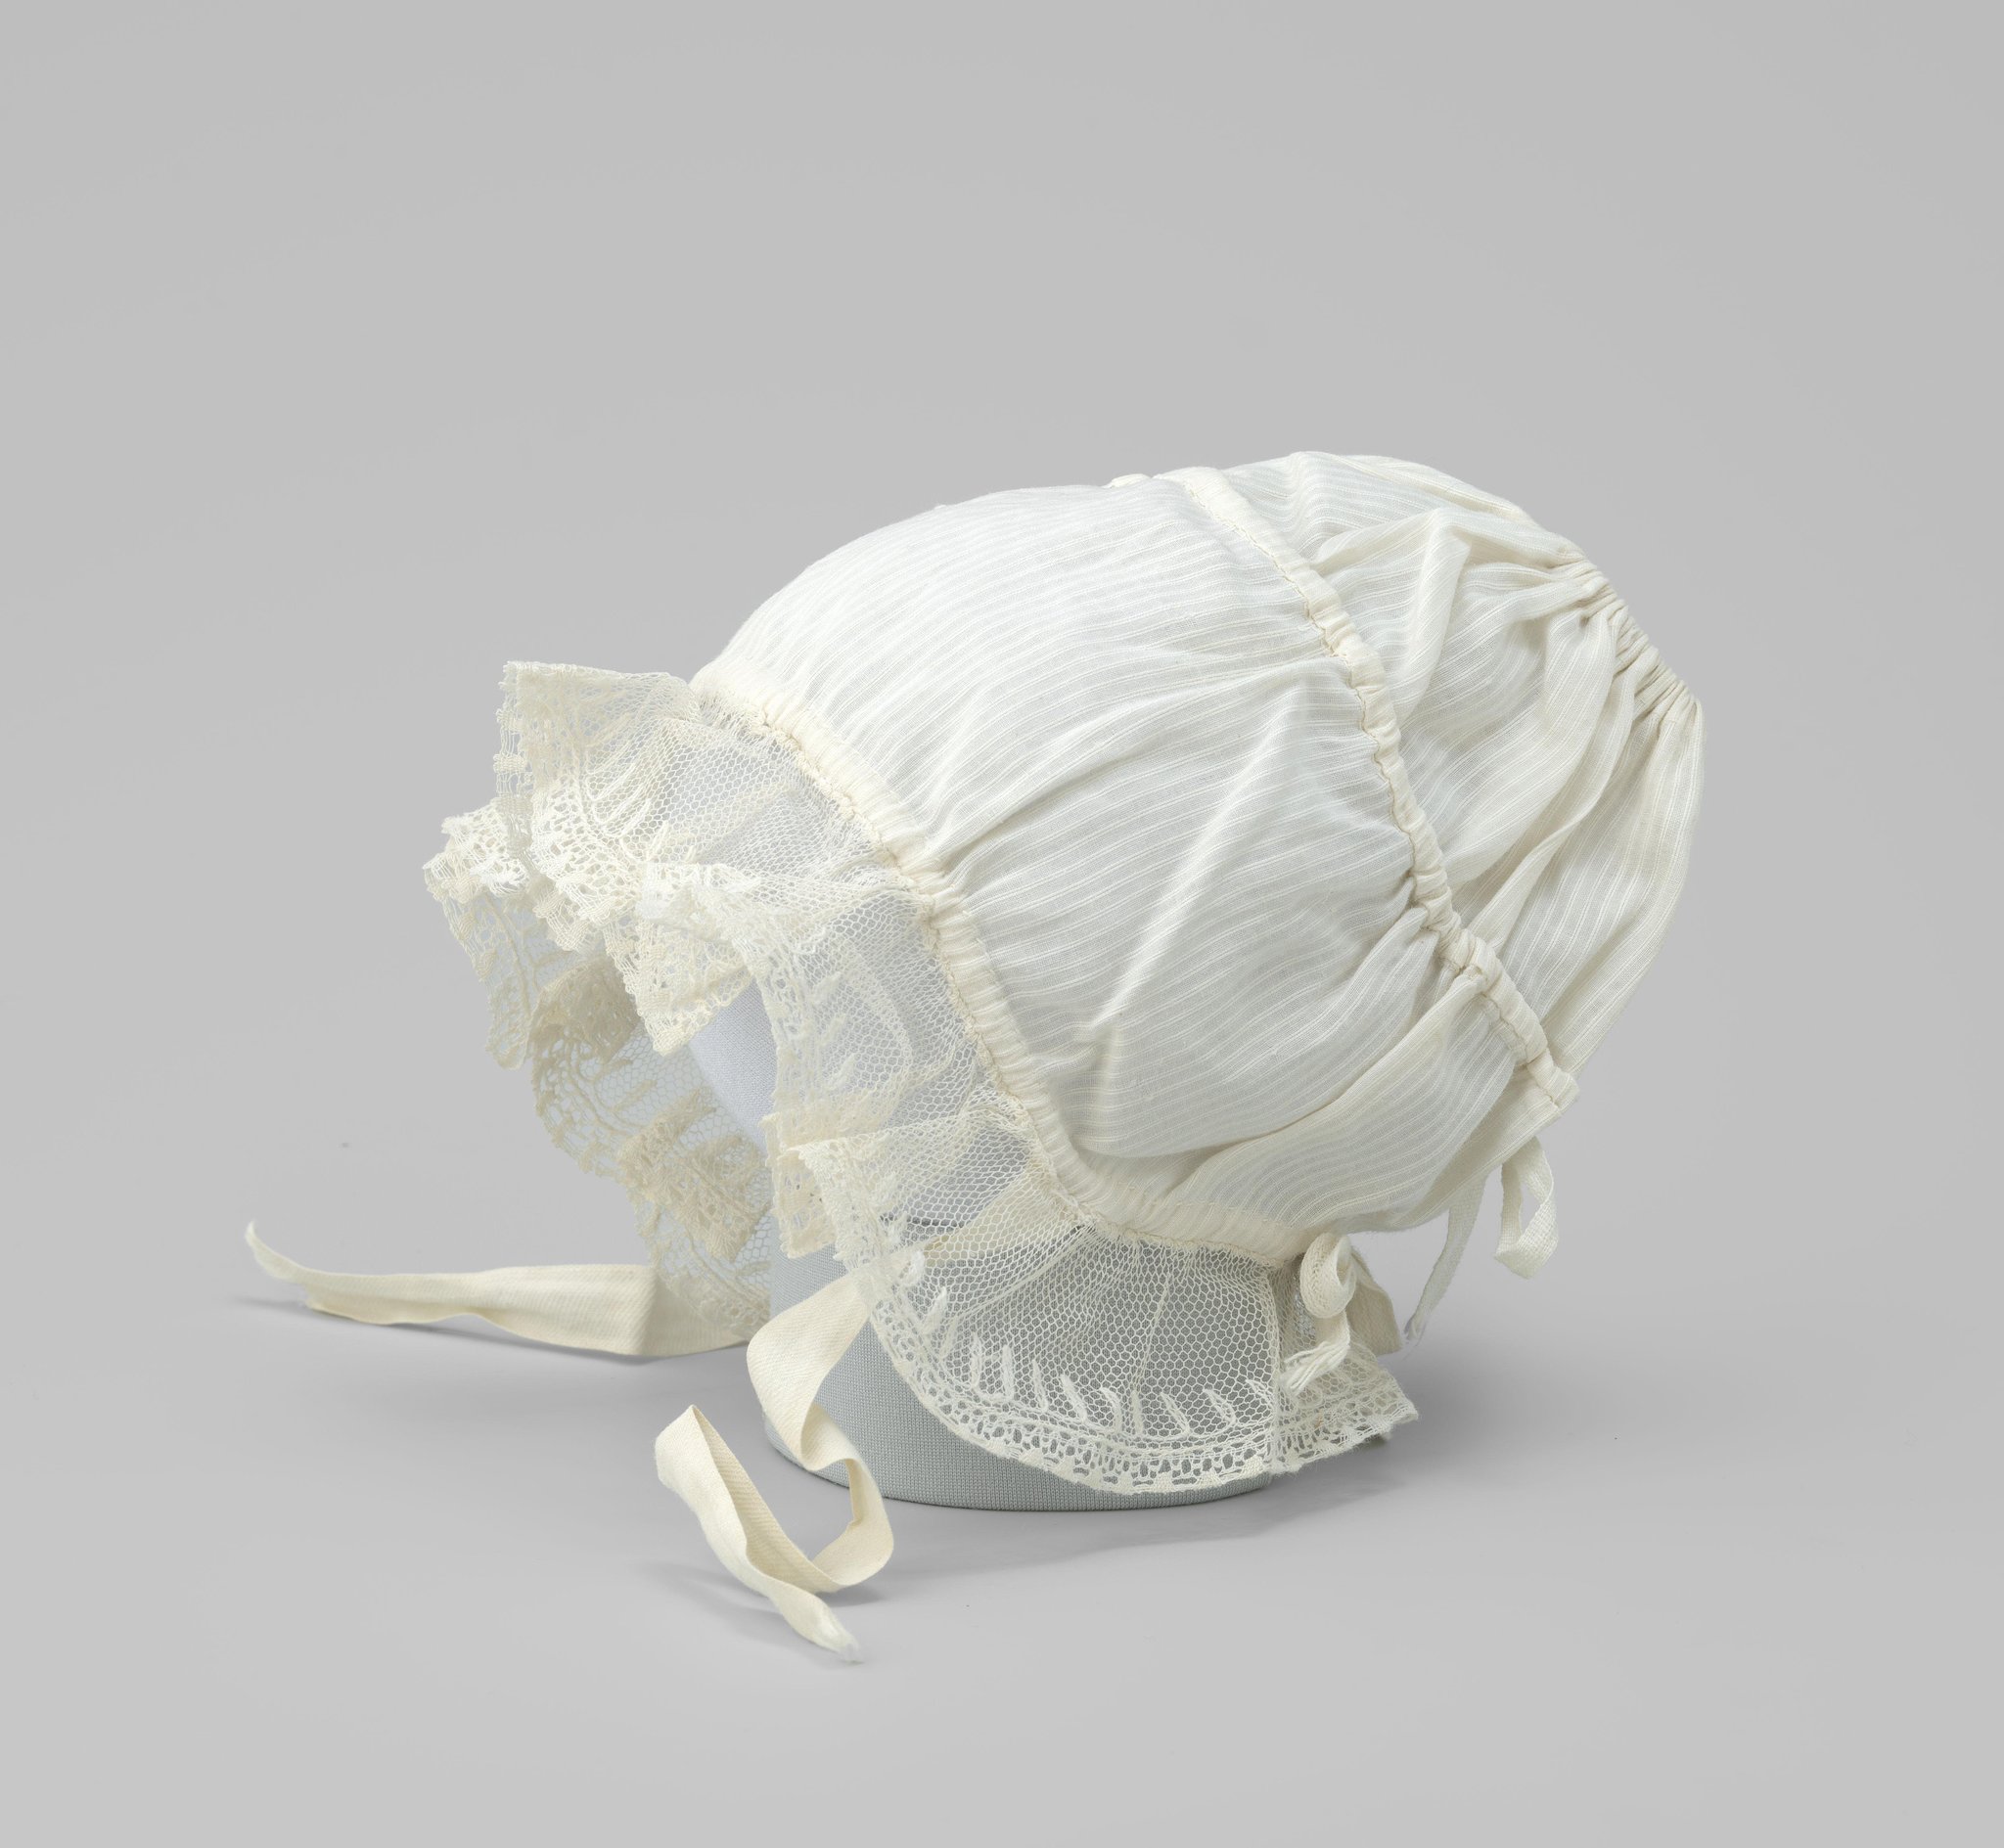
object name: babymuts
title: Babymuts van wit textiel met ingeweven streep met gerimpeld aangezette strook tule met tuledoorstopwerk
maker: Anonymous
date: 1800-1900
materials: textile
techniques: embroidered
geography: netherlands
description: De muts heeft drie tunnels waardoorheen een strik is geregen. De muts kan worden bevestigd met een strik van wit lint.